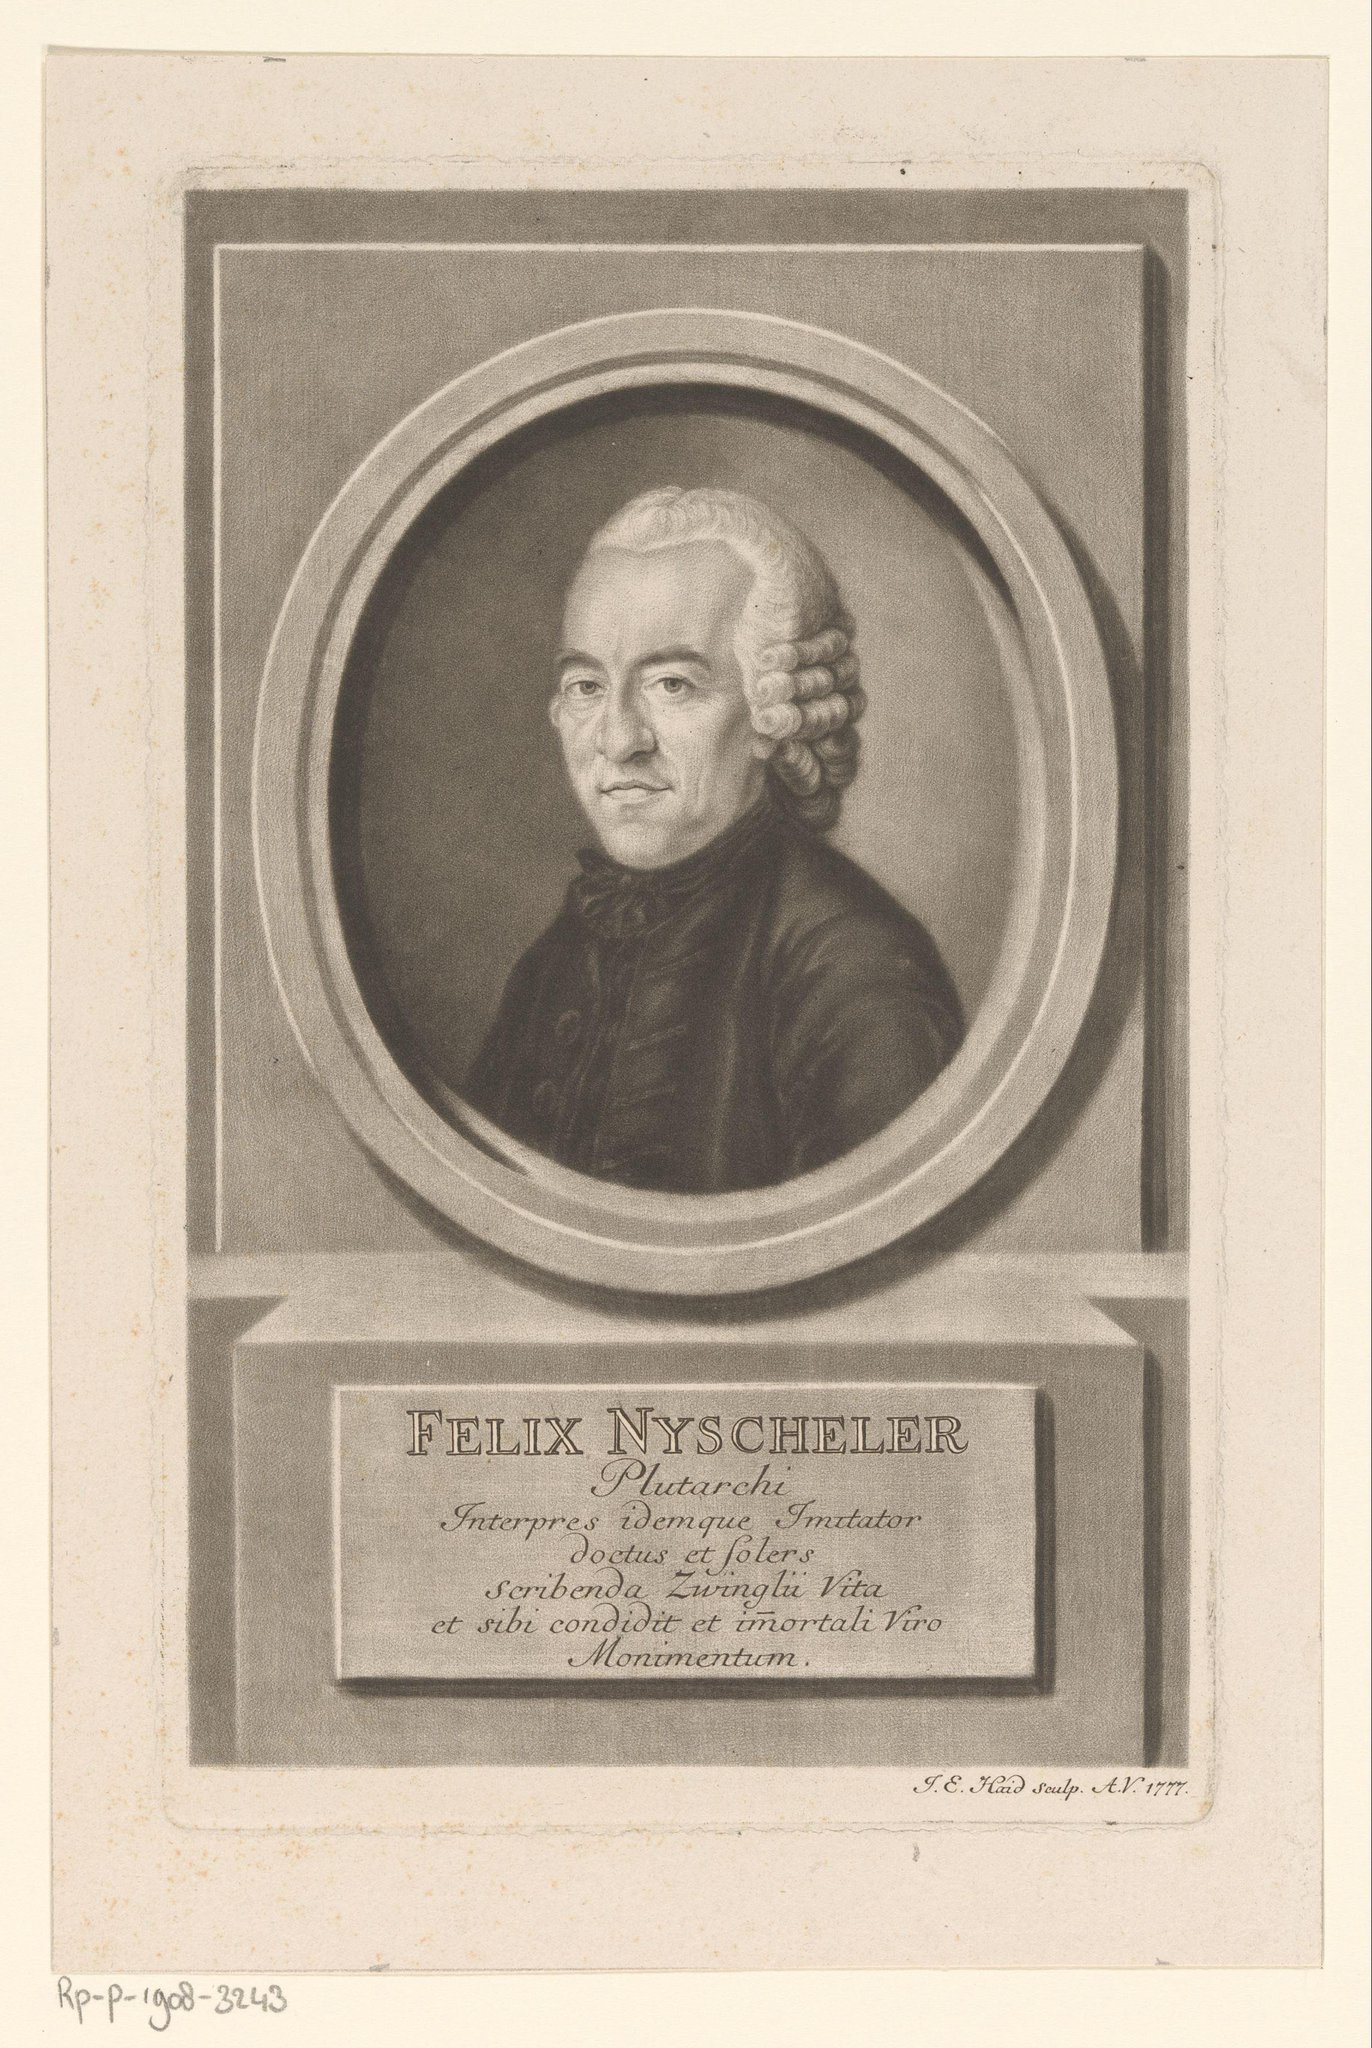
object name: print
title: Portret van Felix Nyscheler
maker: johann elias haid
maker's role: print maker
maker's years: 1739-1809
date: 1777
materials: paper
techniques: mezzotint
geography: augsburg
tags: theologian, historical persons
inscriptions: collector's mark: Lugt 2228